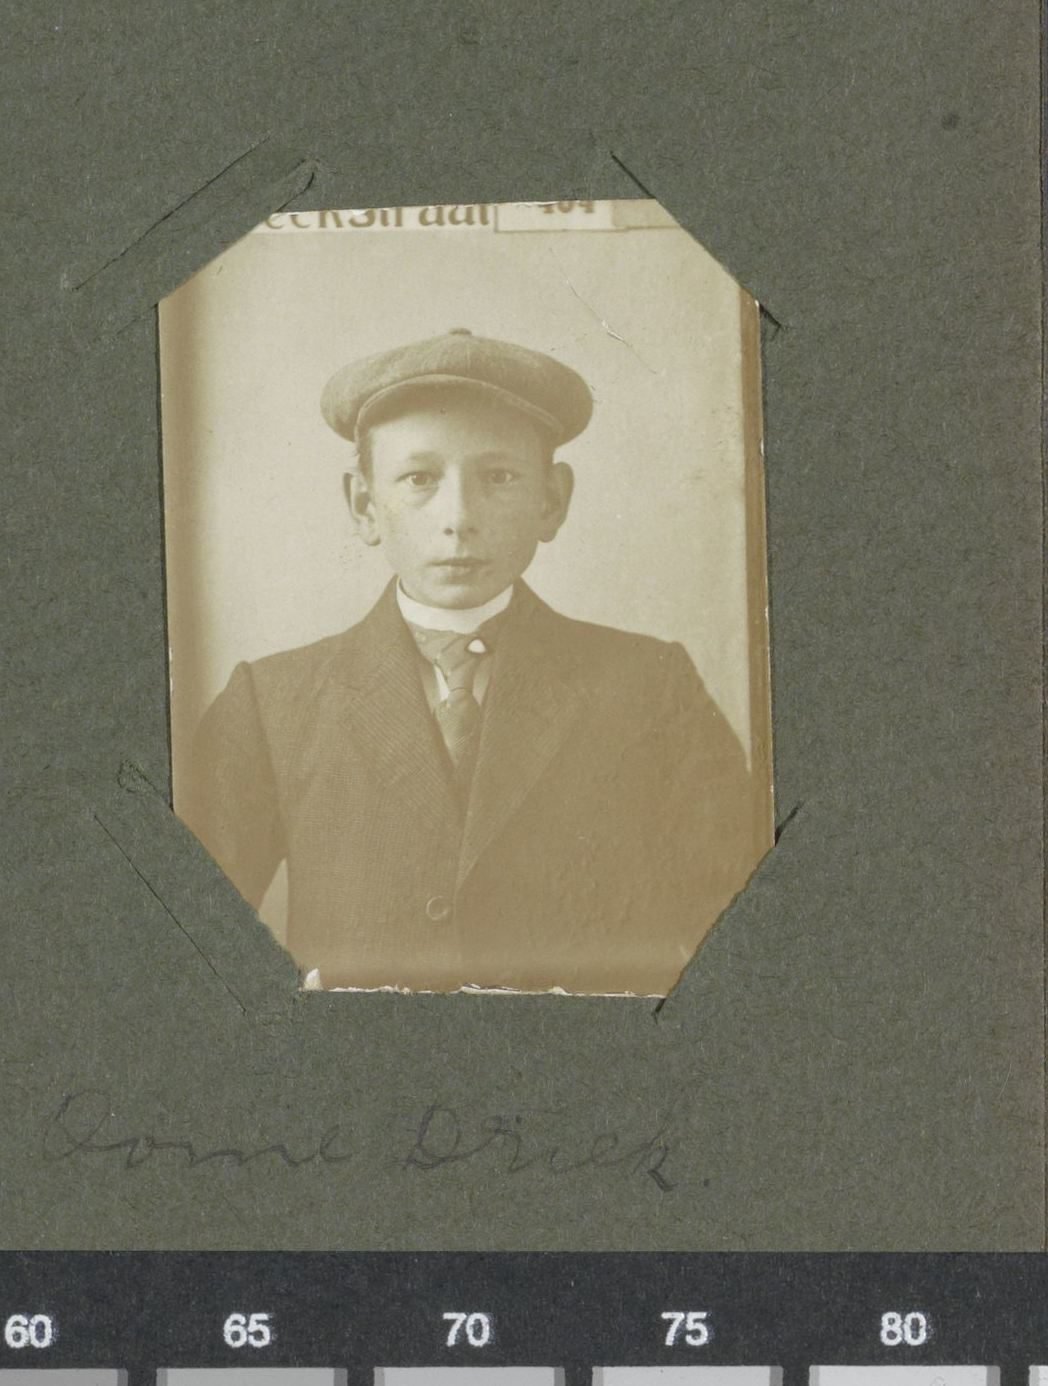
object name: photograph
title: Portret van een jongeman met een pet, aangeduid als 'Oome Driek'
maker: Anonymous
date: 1910-1920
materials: cardboard, paper, photographic support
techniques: gelatin silver print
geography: netherlands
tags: historical persons, youth, adolescent, head-gear: cap, netherlands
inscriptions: address: ‘Beekstraat’, number: ‘404’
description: Onderdeel van Album met automaatfoto's van een Nederlandse familie.